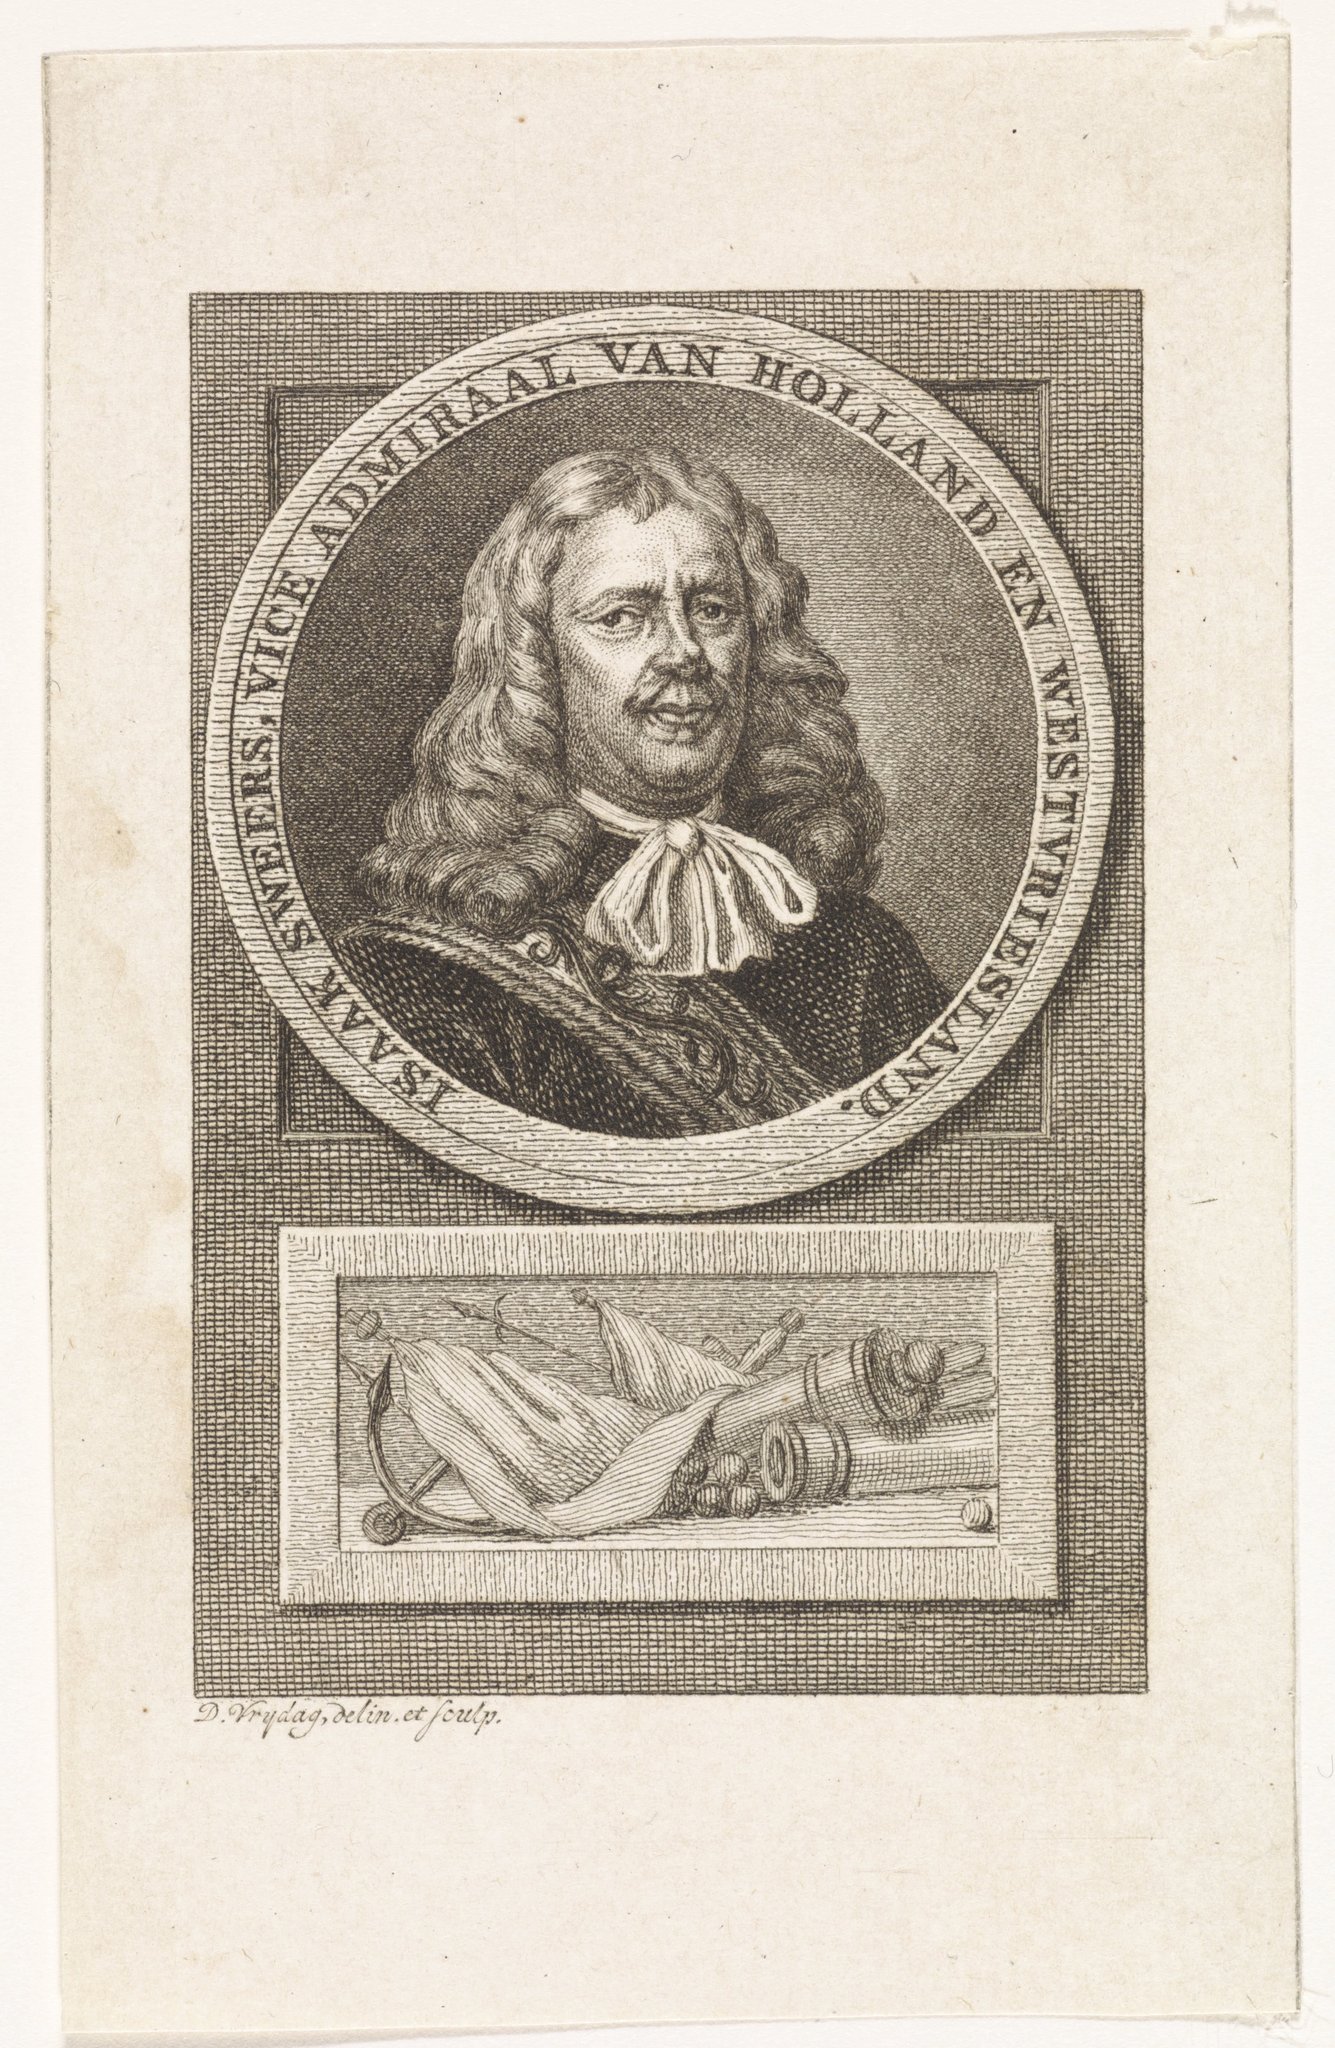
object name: print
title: Portret van de admiraal Isaac Sweers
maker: daniël vrijdag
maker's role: draughtsman, print maker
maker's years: 1765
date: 1780-1822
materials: paper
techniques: engraving, etching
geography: netherlands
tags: nijmegen, parts of ship's exterior: anchor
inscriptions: collector's mark: Lugt 2228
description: In het kader onder zijn portret een anker en kanonnen.